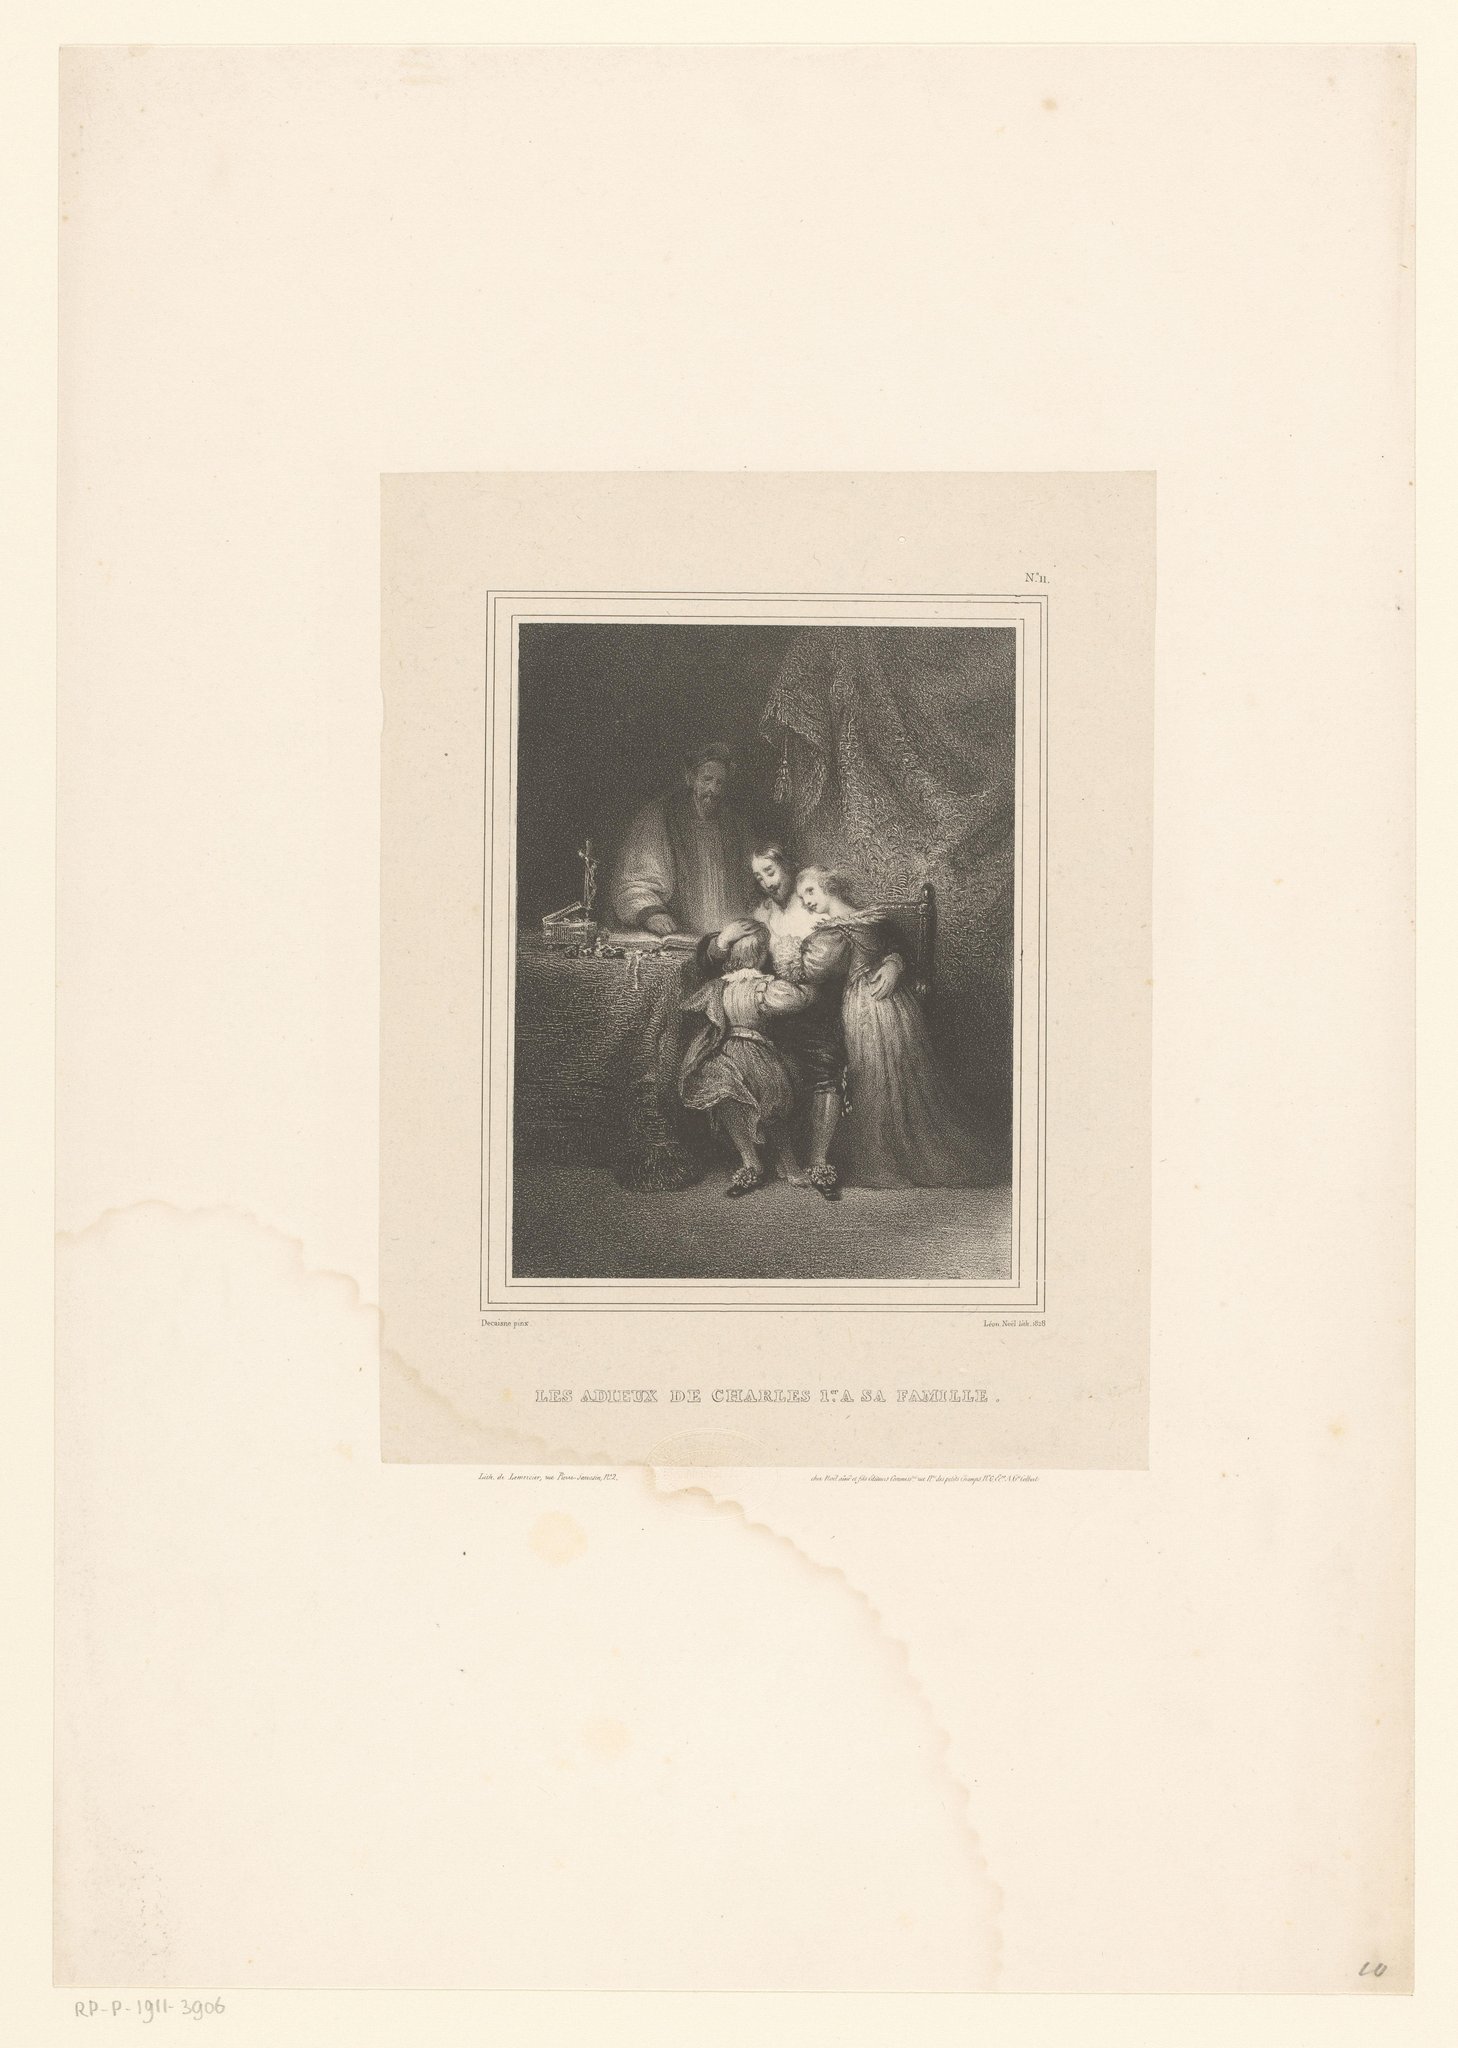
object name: print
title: Album lithographique, douze sujets d'après Decaisne par Léon Noël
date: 1828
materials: paper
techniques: lithograph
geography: paris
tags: brothers or sisters (second degree family relationships), waving farewell ~ departure on a journey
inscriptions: check stamp: Lugt 4944, collector's mark: Lugt 2228